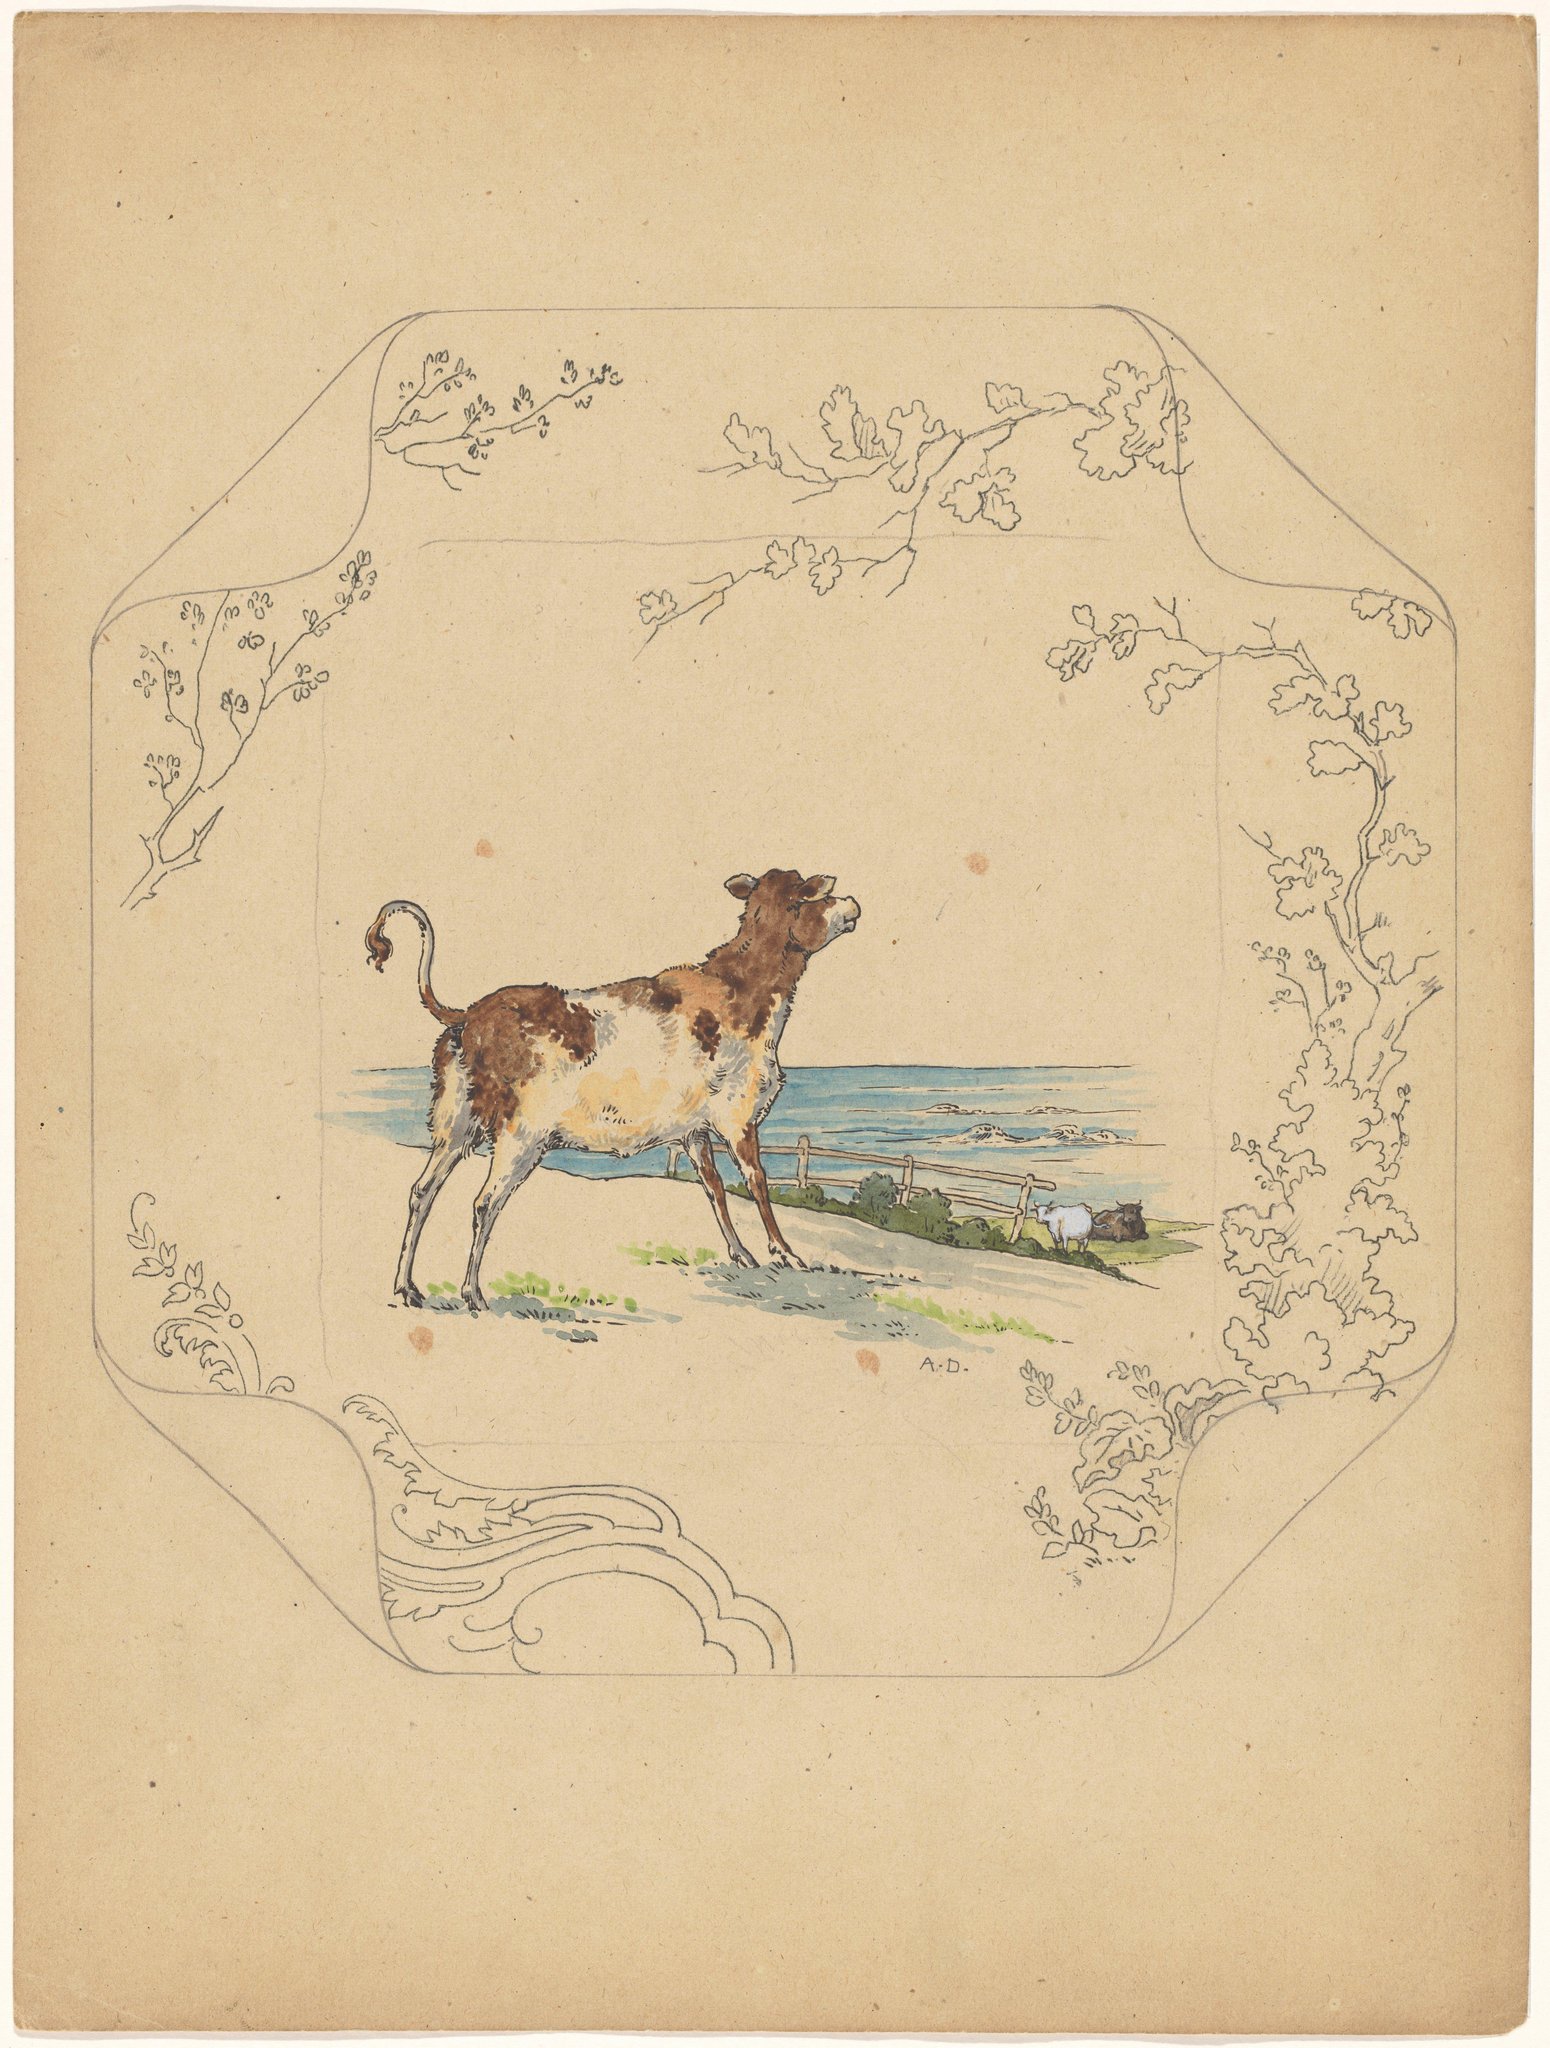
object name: drawing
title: Ontwerp voor bord van het model ‘Square’ met koeien aan zee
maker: albert louis dammouse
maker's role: ceramicist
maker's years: 1848-1926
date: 1875-1880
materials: paint, graphite, ink, paper, watercolor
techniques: brush, pen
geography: sèvres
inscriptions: monogram: ‘A.D.’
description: Het plat gedecoreerd met een koe bij de zee, met twee koeien op de achtergrond.